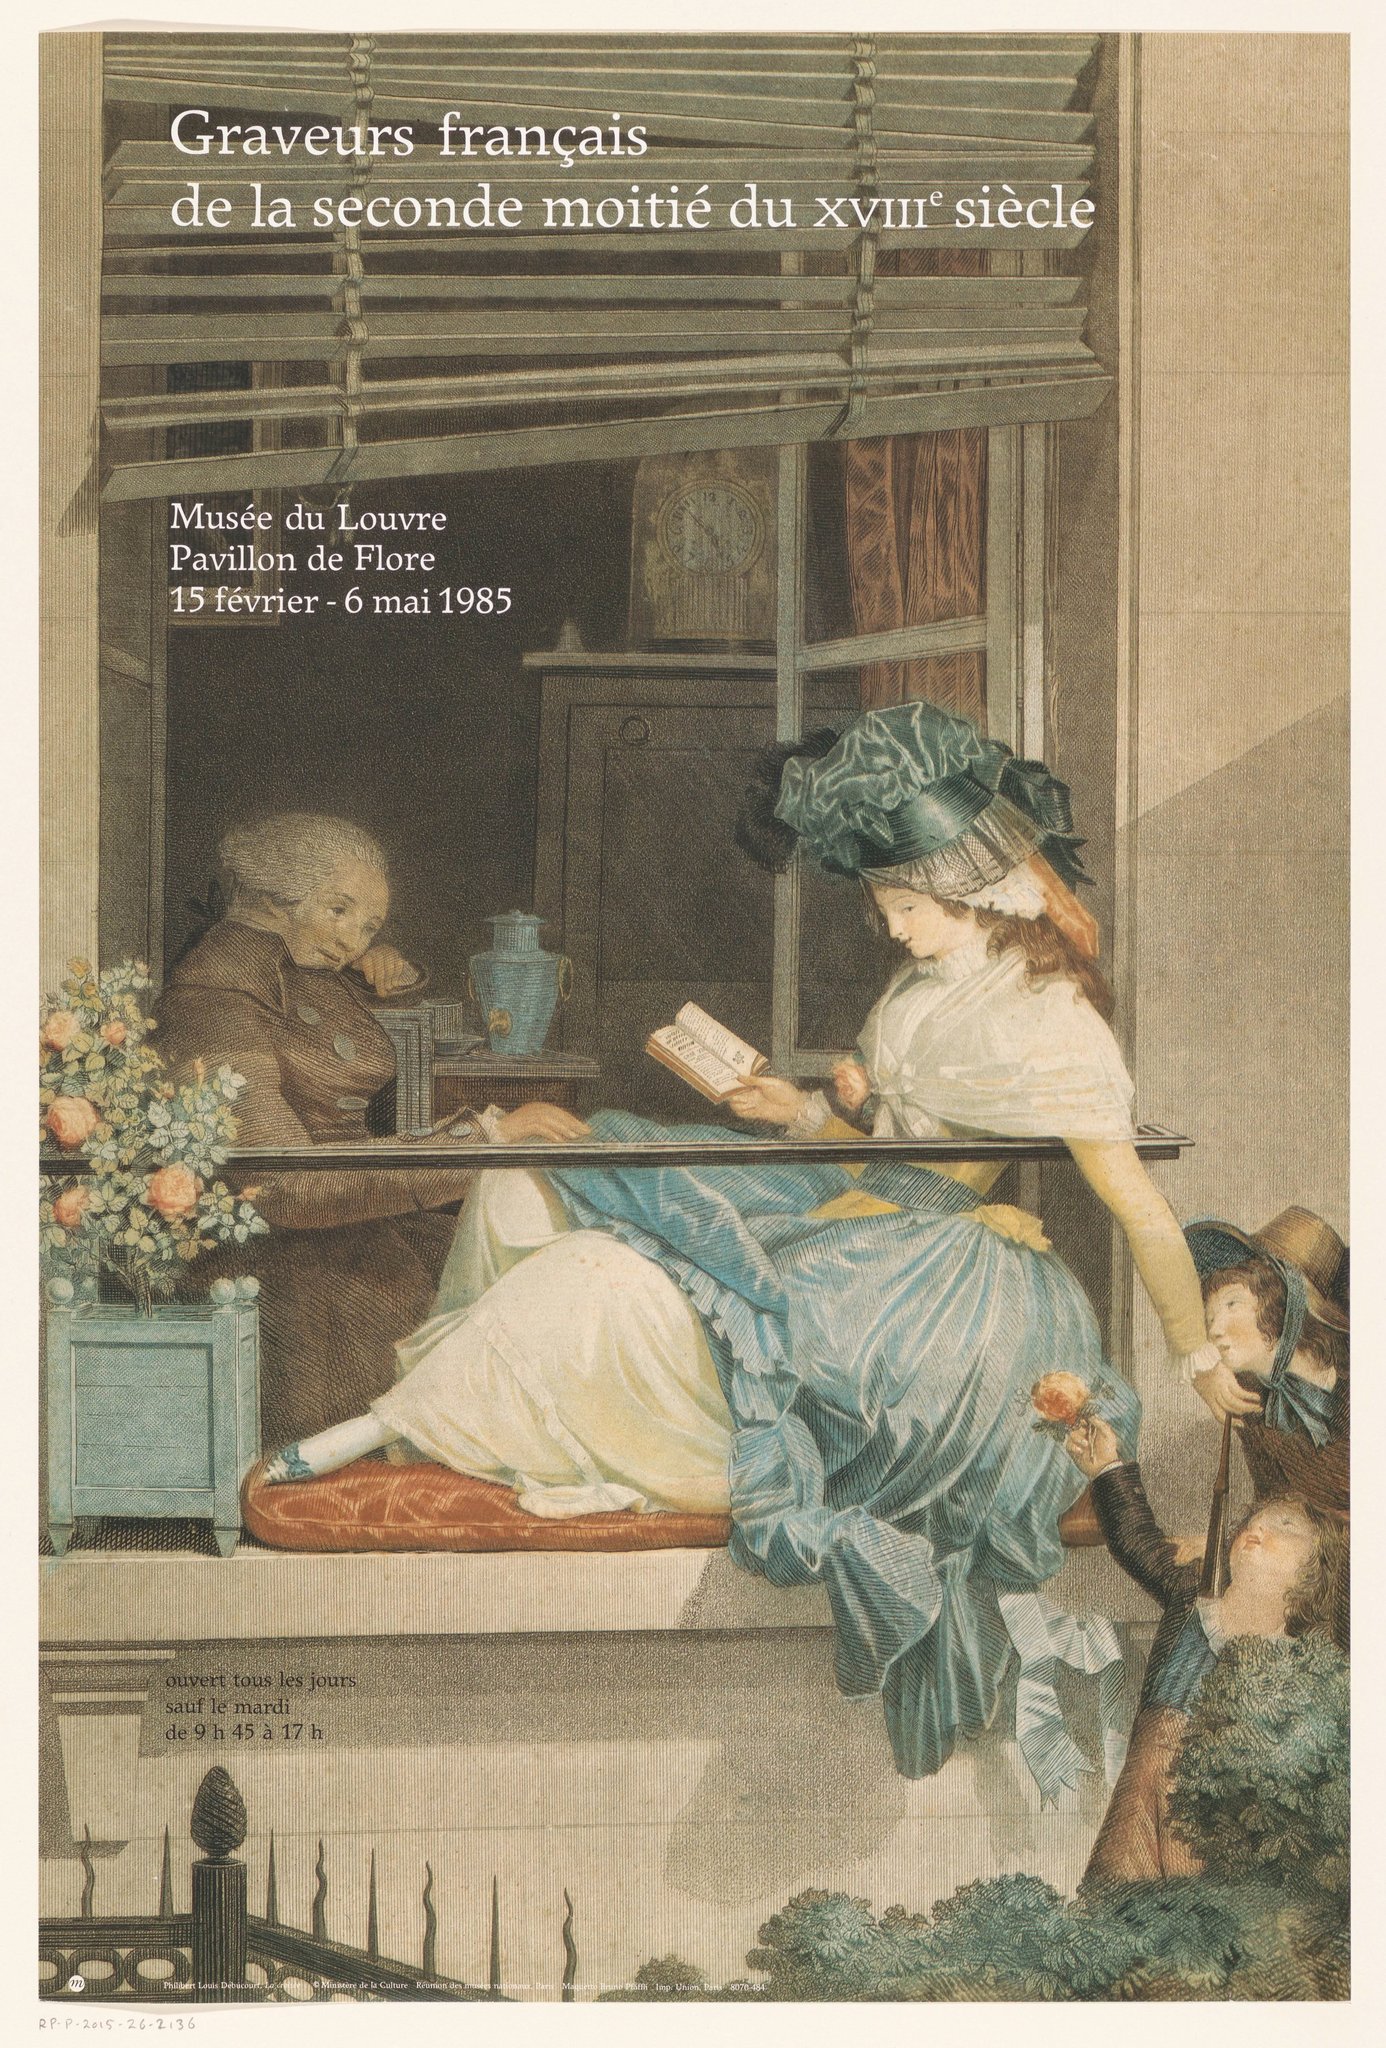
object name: poster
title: Affiche voor de tentoonstelling Graveurs français de la seconde moitié du XVIIIe siècle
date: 1985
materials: paper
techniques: mechanical printing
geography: paris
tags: reading, fan, book, balcony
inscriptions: collector's mark: Lugt 2228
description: Op het affiche een fragment van een prent van Philibert-Louis Debucourt, voorstellend een man en een lezende vrouw op een balkon. De vrouw duwt met haar waaier twee kinderen weg die op de grond staan.